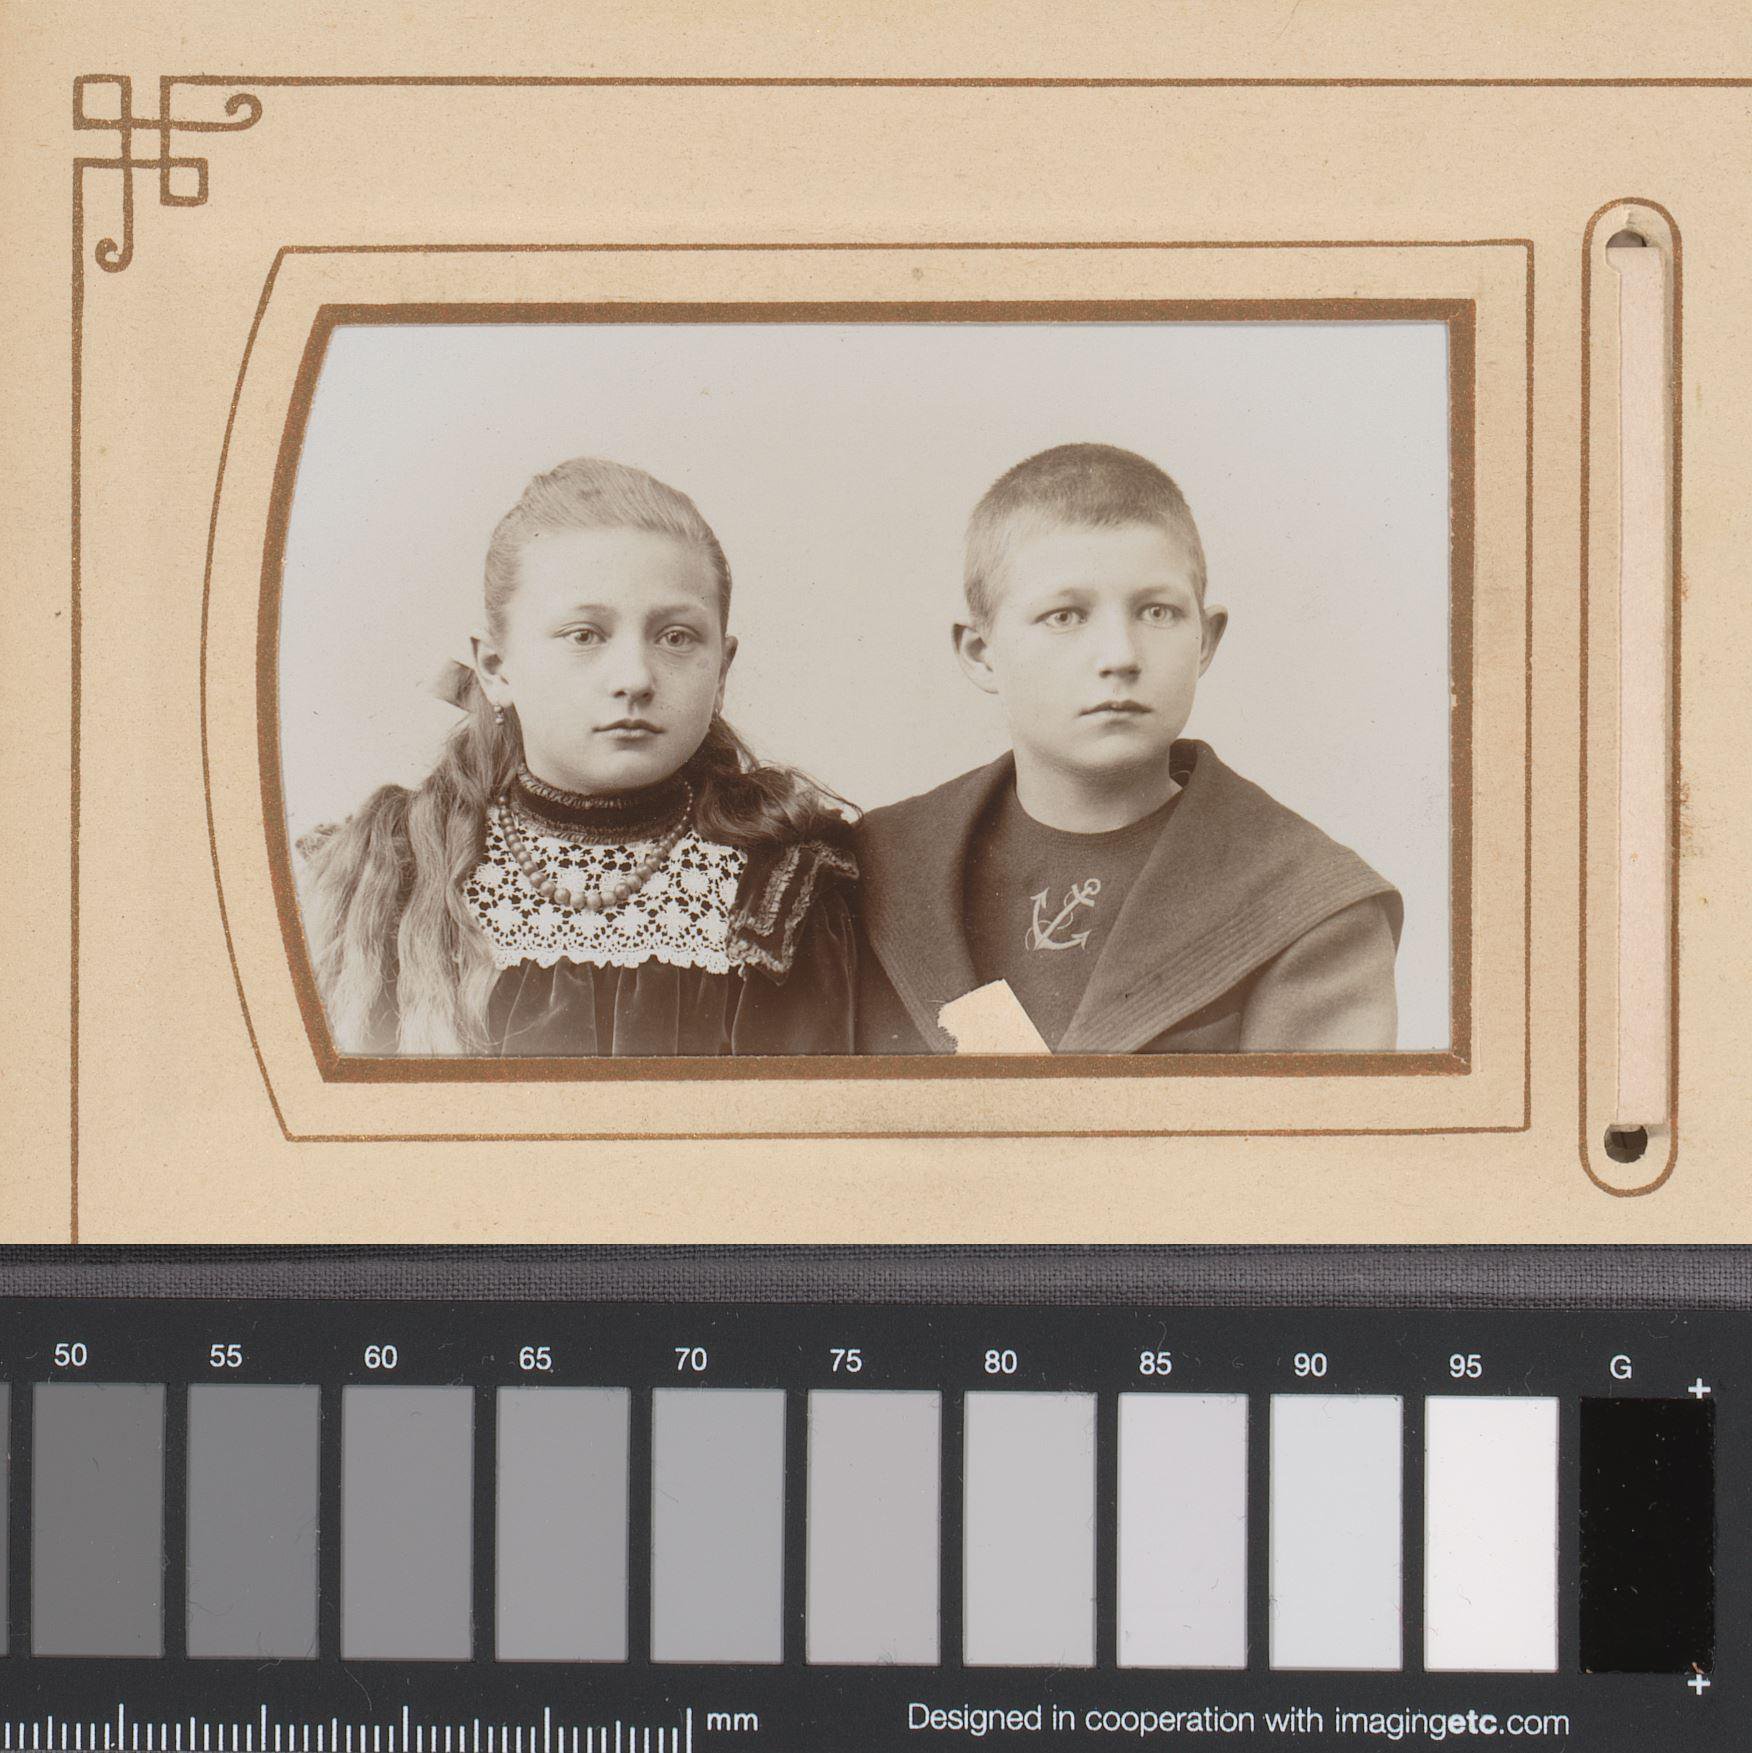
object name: album leaf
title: Portret van een jongen en een meisje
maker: hermann tietz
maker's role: fotograaf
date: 1890-1910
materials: cardboard, photographic support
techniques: collodion silver print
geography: hamburg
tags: boy (child between toddler and youth), girl (child between toddler and youth)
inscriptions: inscription: ‘Hermann Tietz/ Hamburg/ Gr. Burstah 12-14’